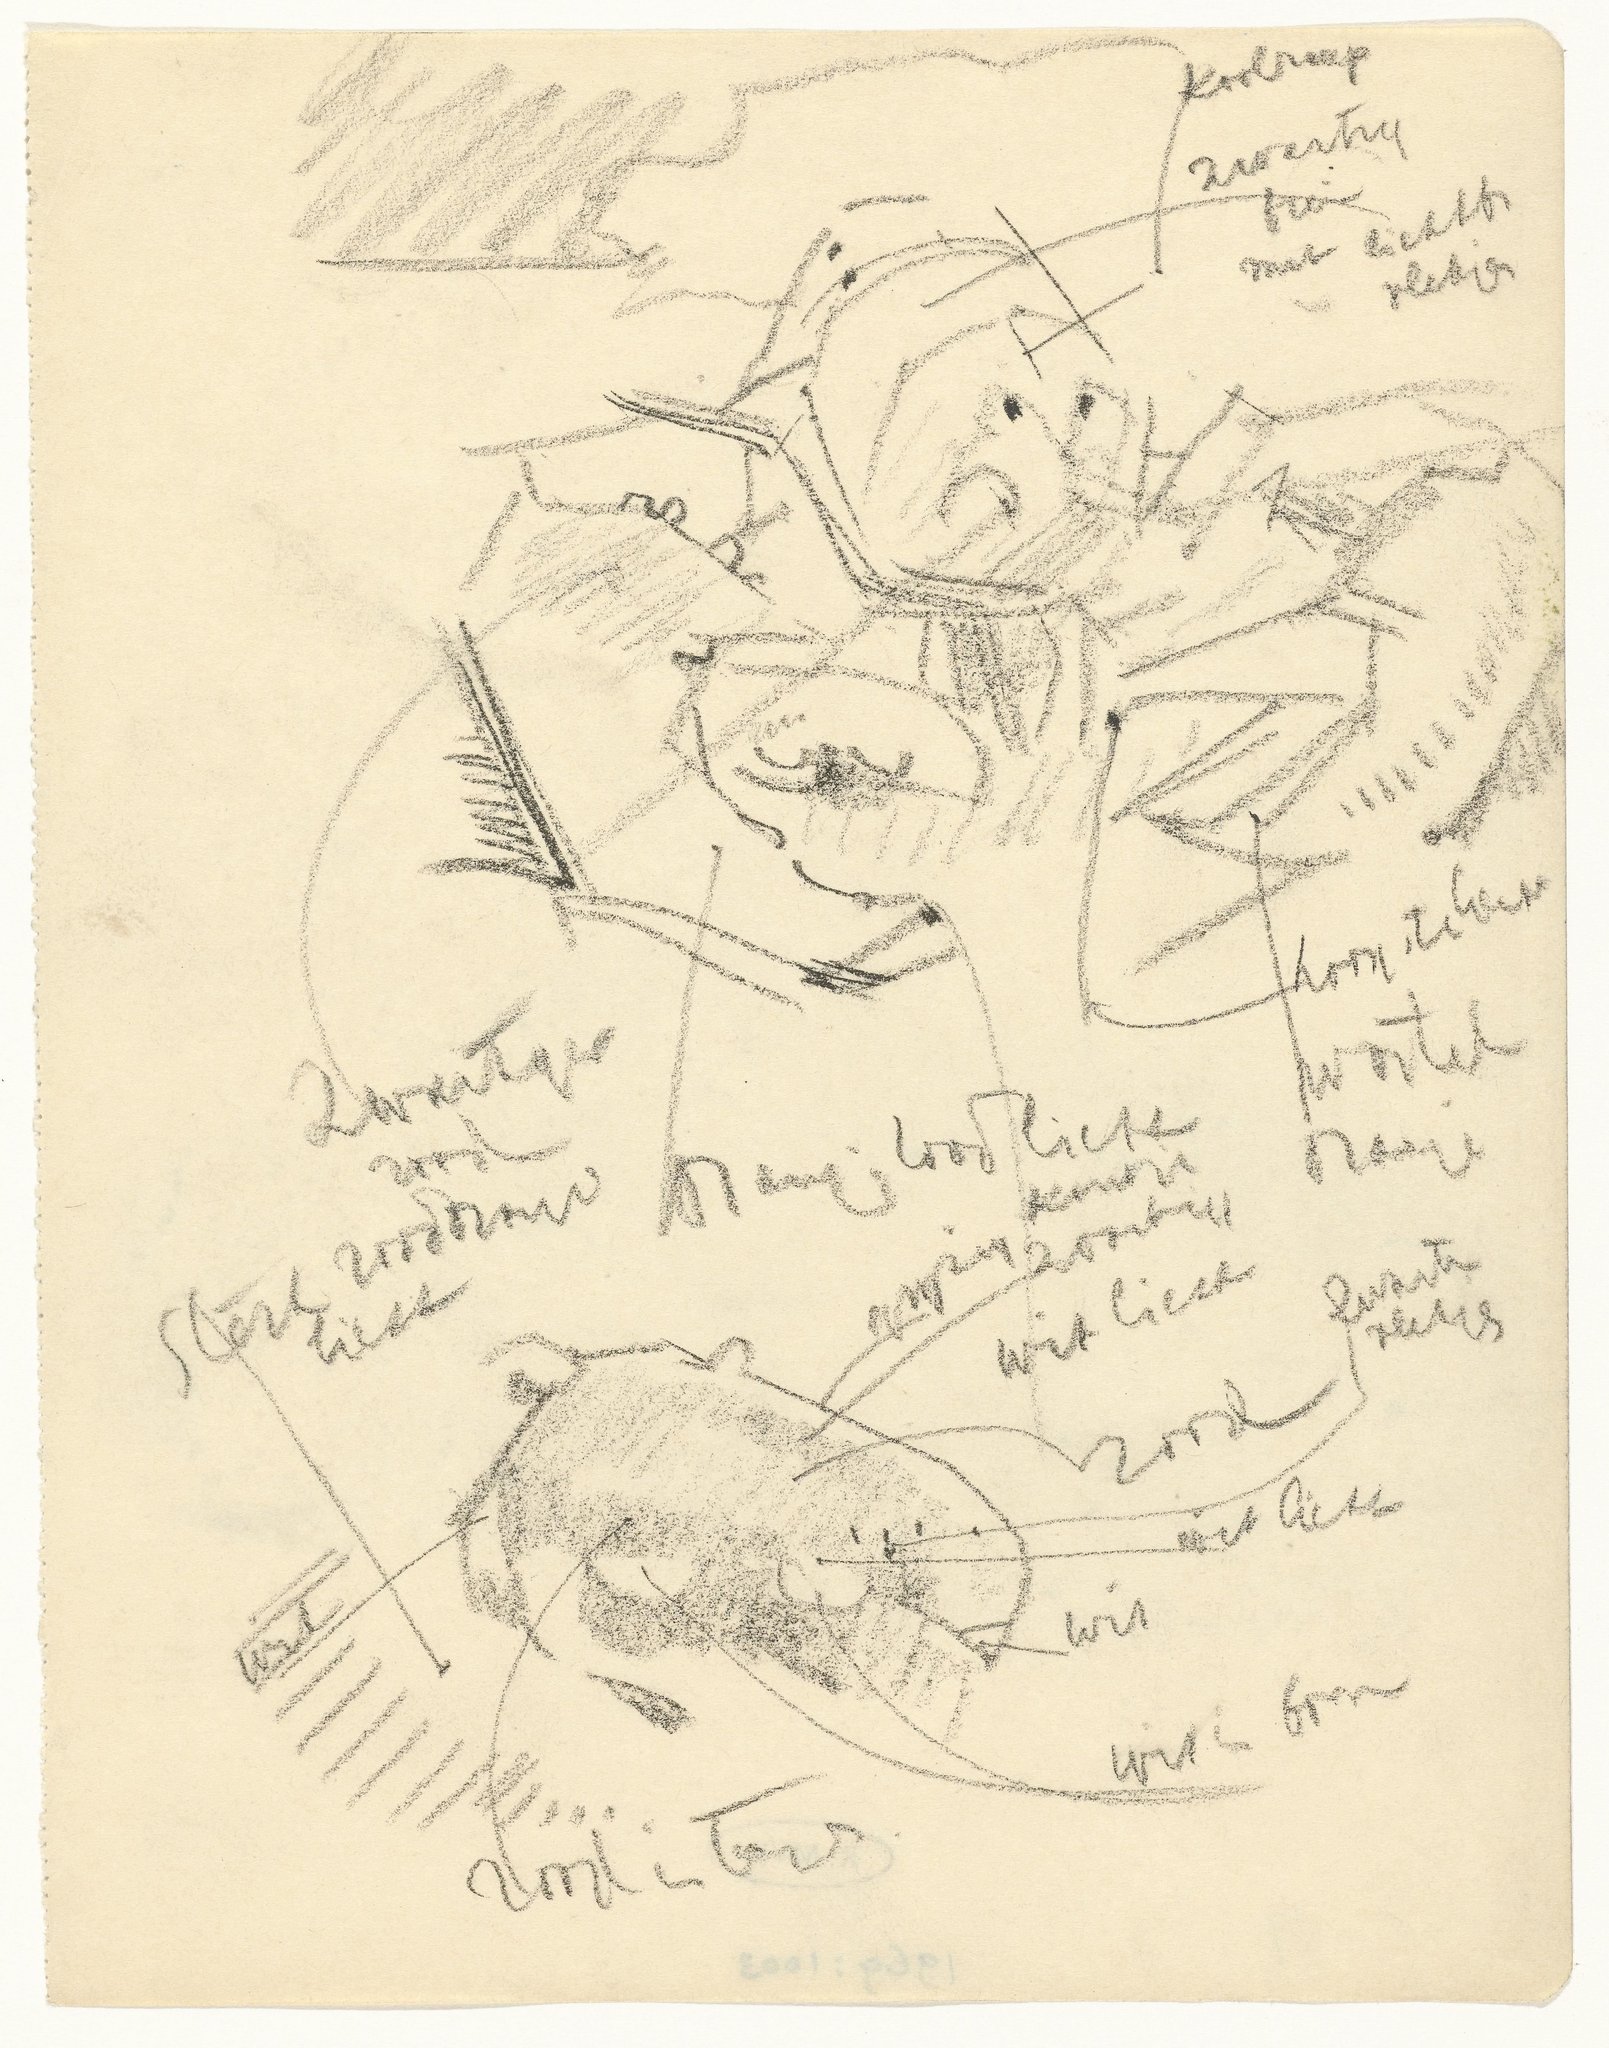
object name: drawing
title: Studies van een kreeft, met kleurnotities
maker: gerrit willem dijsselhof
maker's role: designer, draughtsman, print maker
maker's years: 1866-1924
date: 1876-1924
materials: chalk, paper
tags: crustaceans: lobster